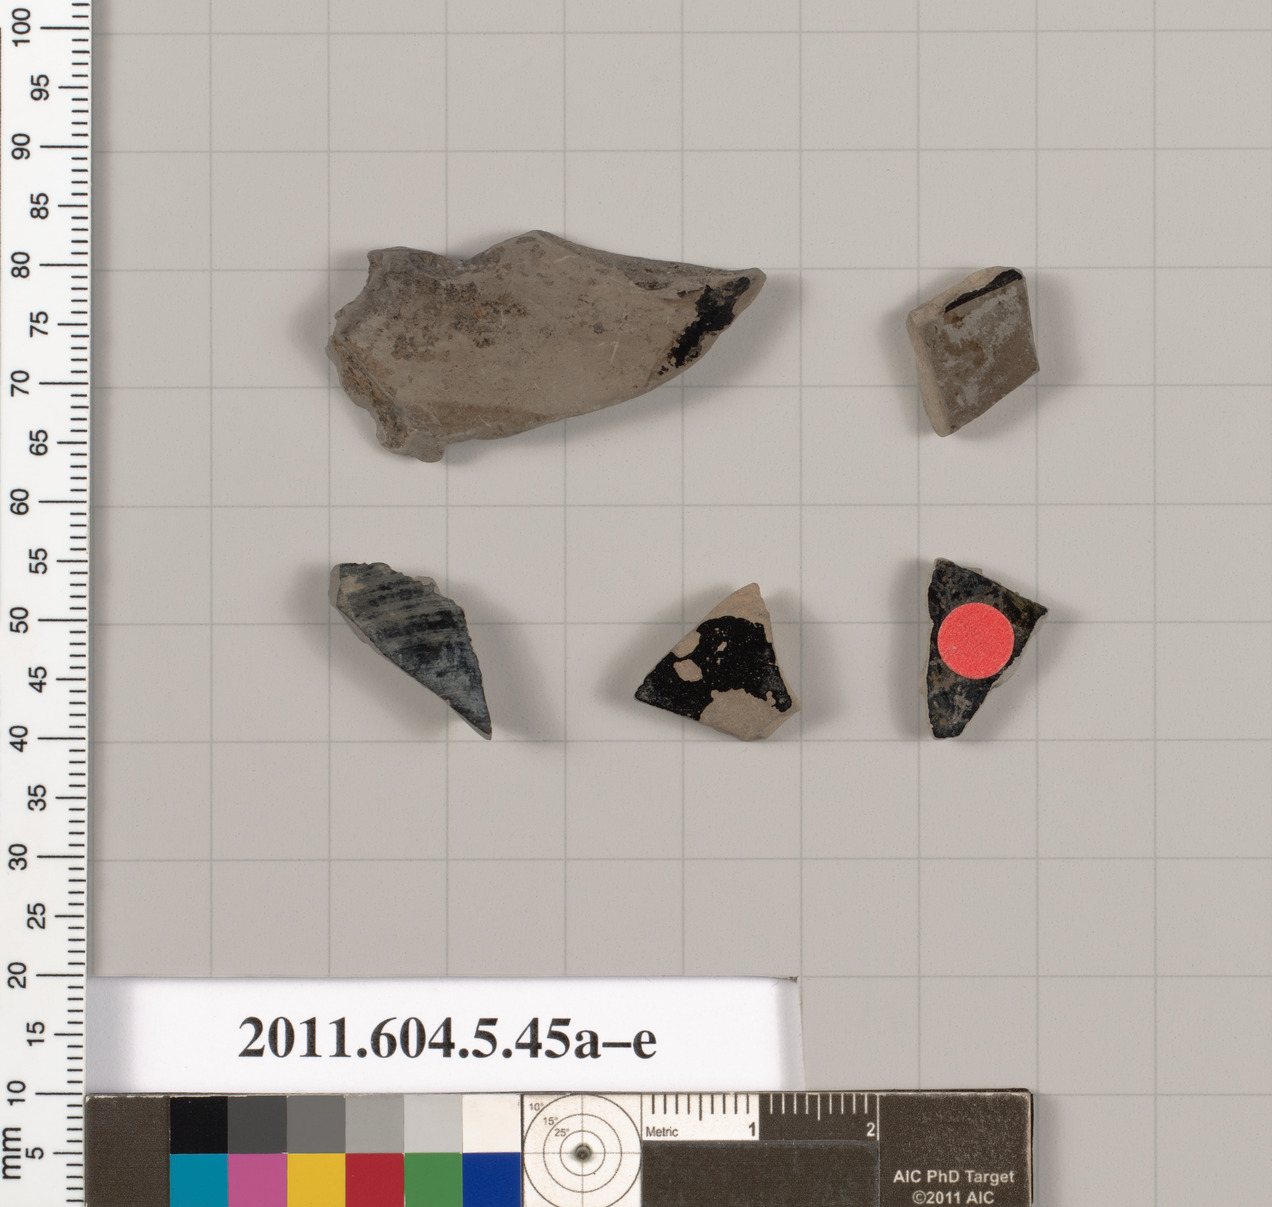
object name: kylix fragment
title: Terracotta fragments of kylikes (drinking cups)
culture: greek, attic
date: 500-401 BCE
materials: terracotta